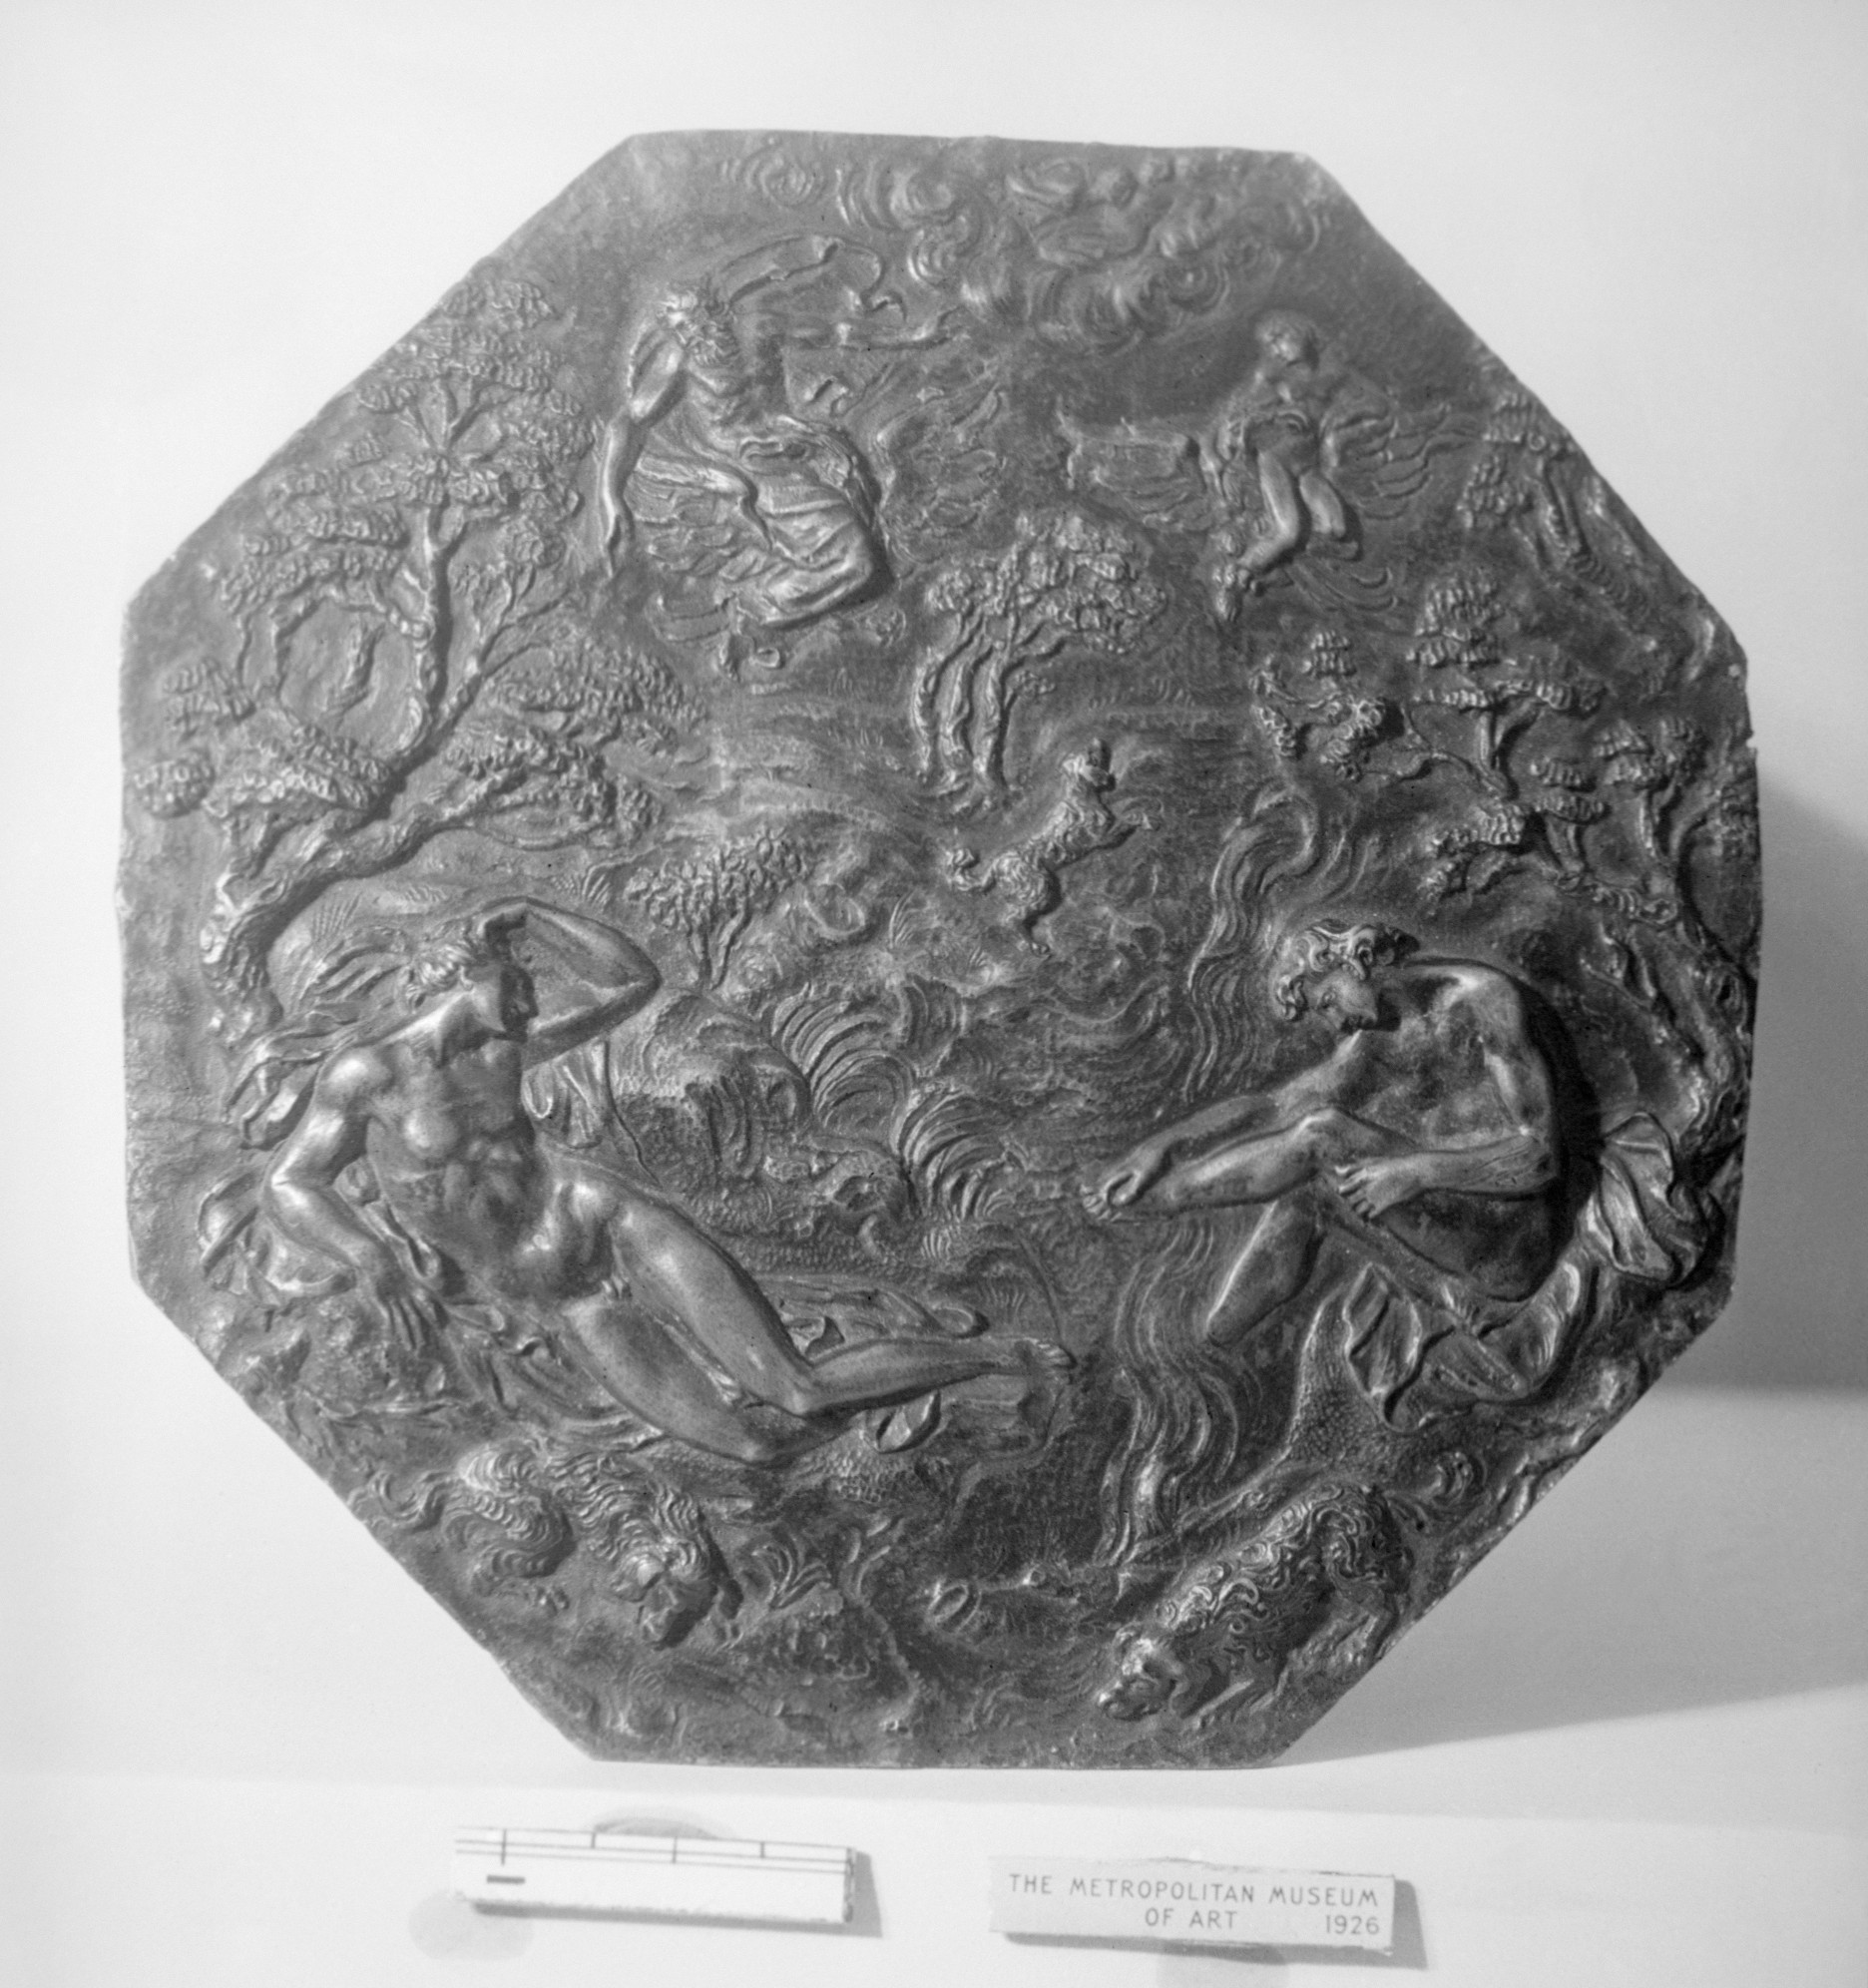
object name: plaquette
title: Legend of Ganymede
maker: guglielmo della porta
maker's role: artist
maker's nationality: italian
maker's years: 1500-1577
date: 1567-1633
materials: bronze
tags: male nudes,dogs